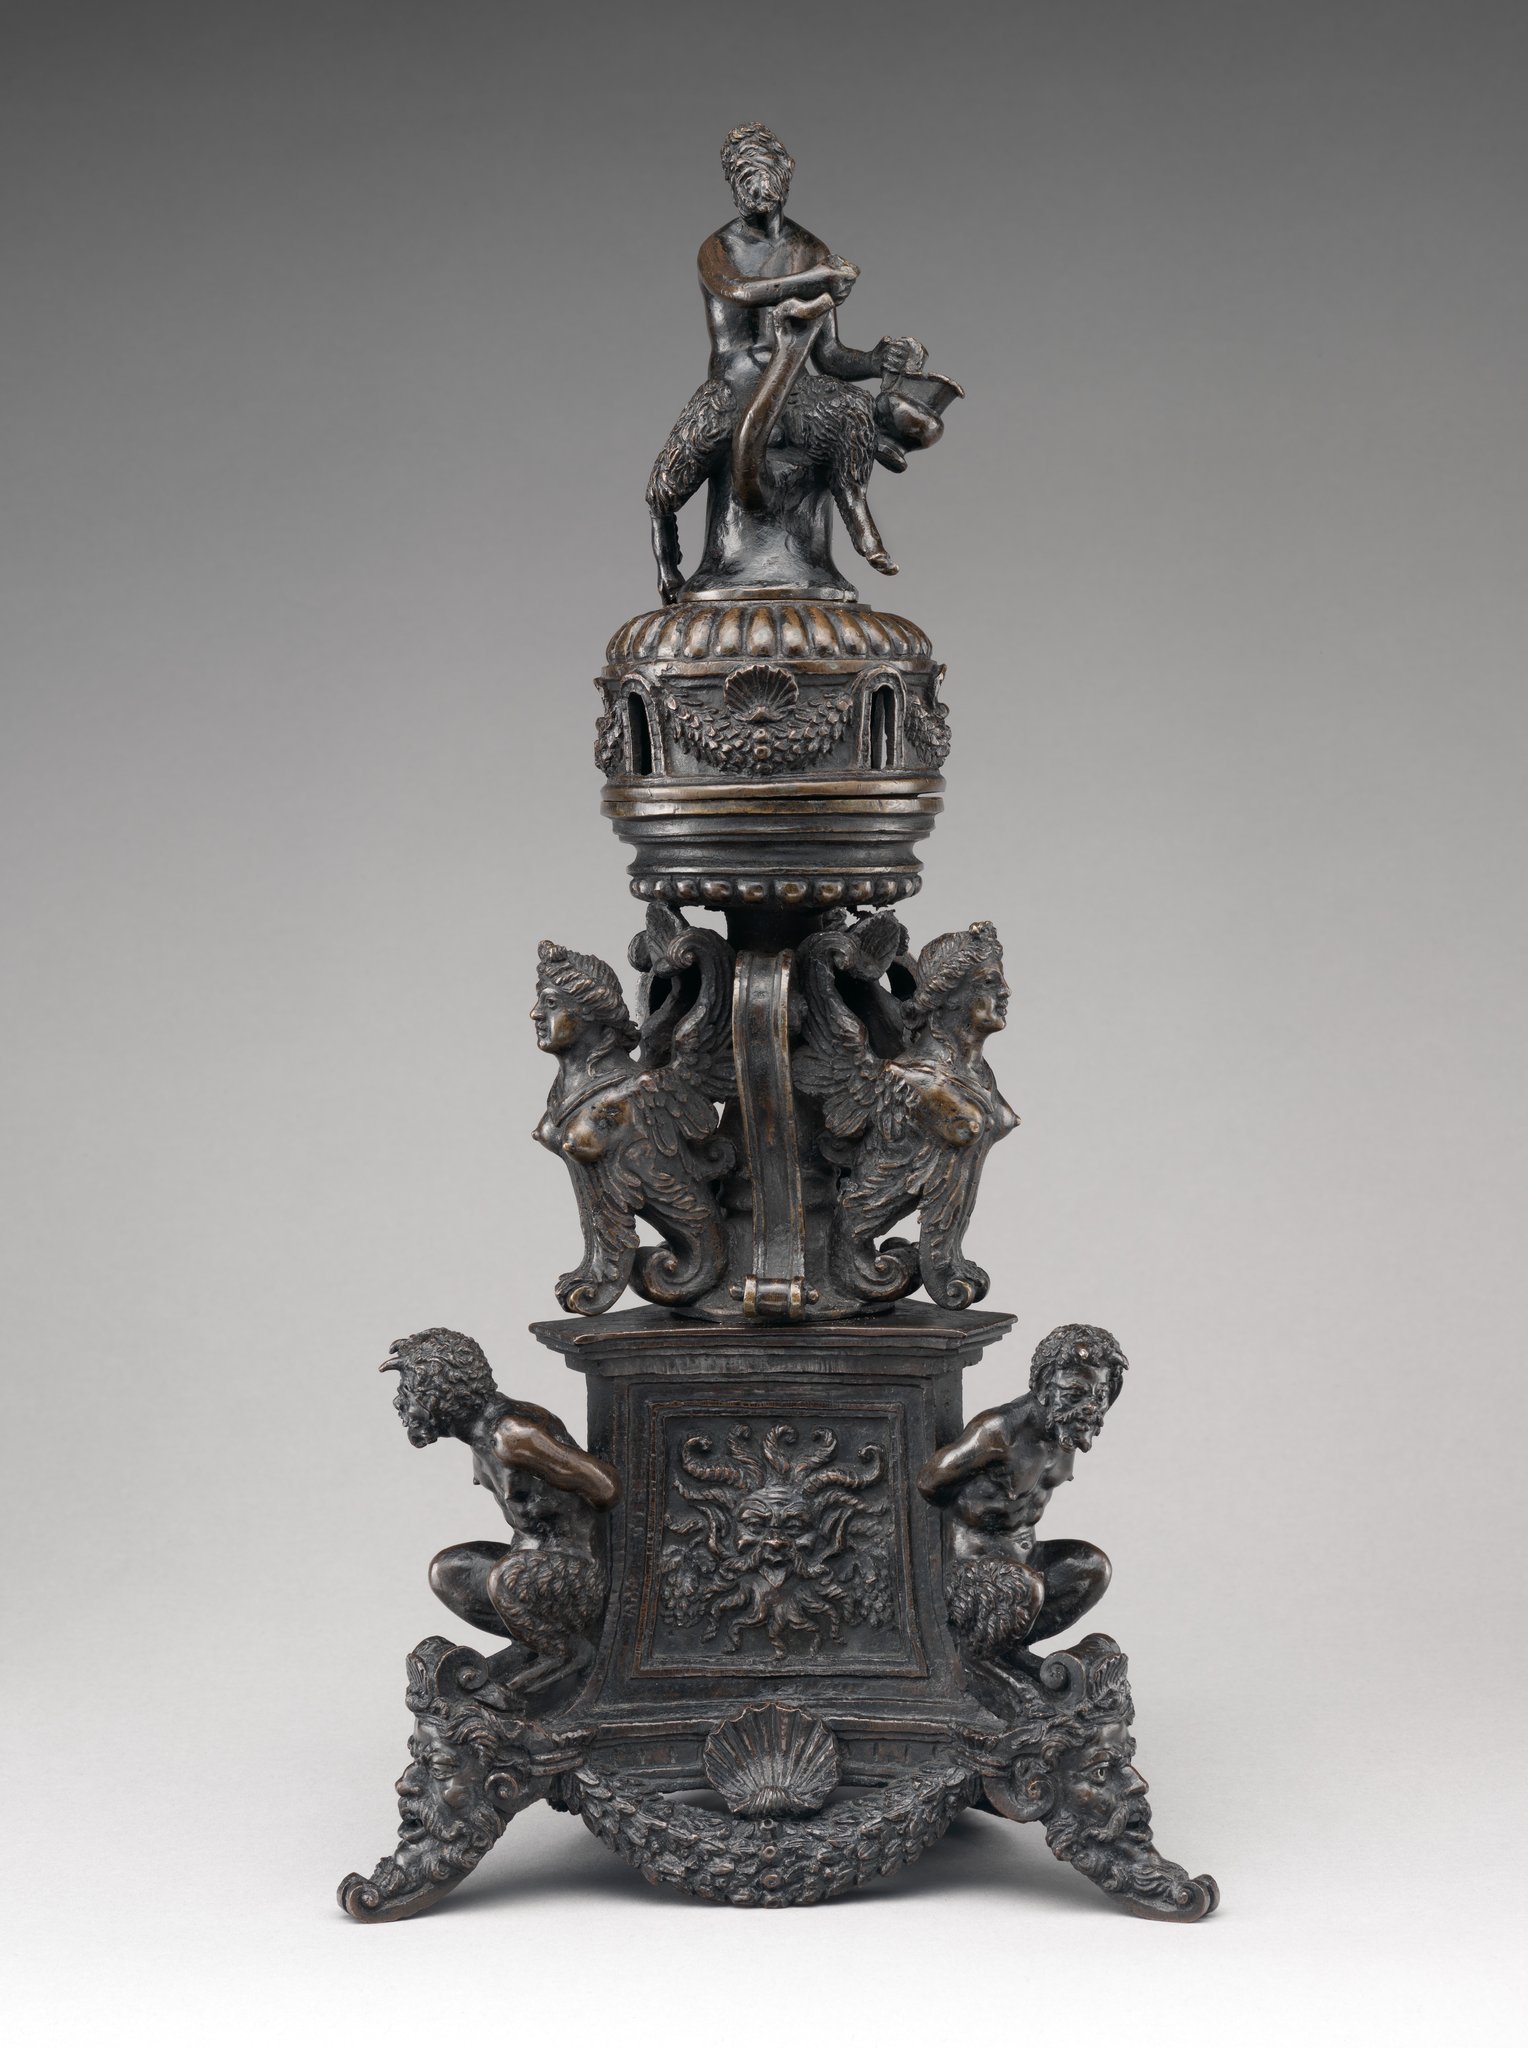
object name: incense burner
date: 1550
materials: bronze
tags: satyrs